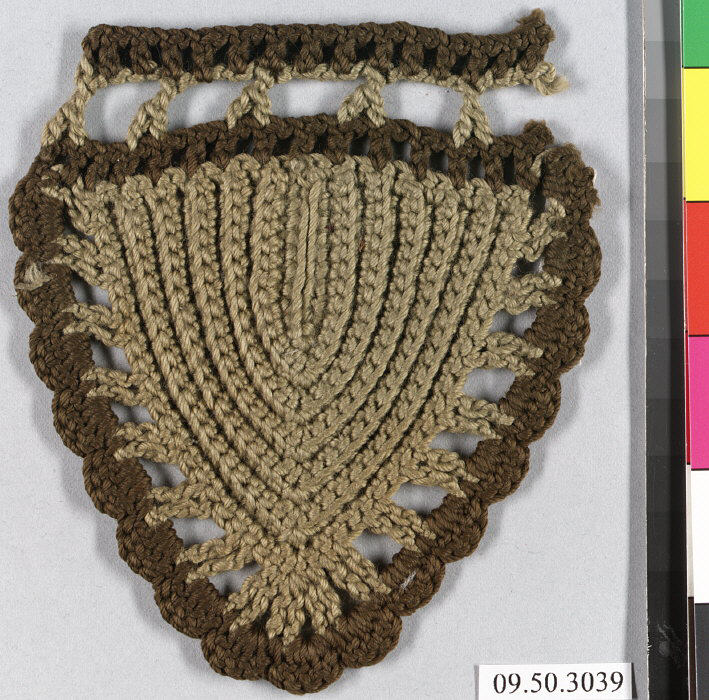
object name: sample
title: Crochet Work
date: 1801-1900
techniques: crochet